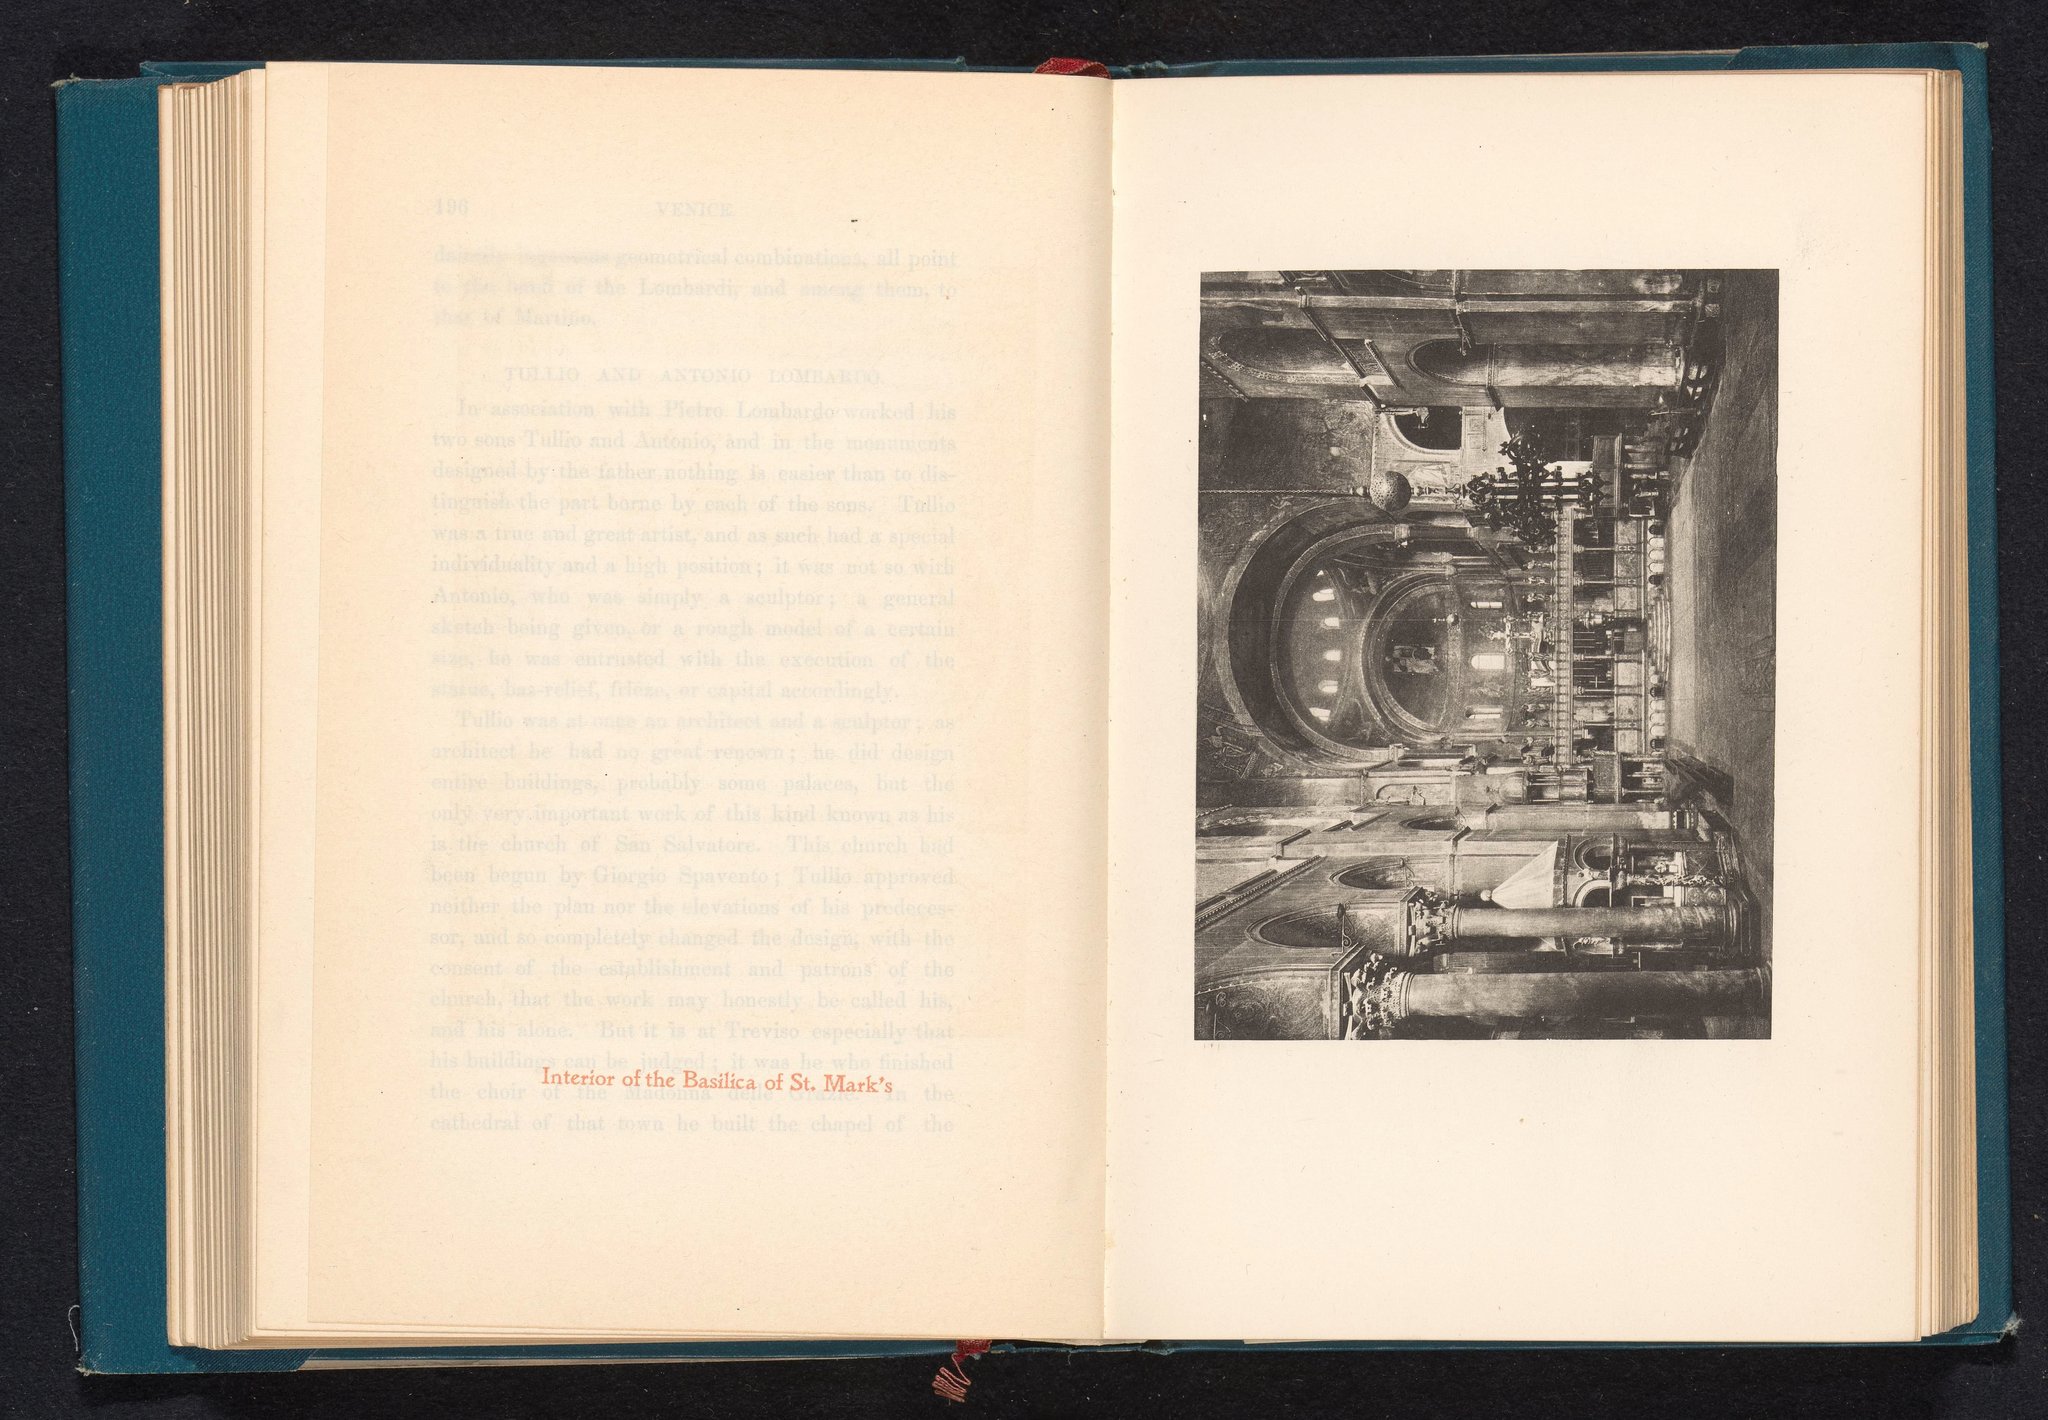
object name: page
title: Interieur van de San Marco te Venetië met zicht op het koor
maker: Anonymous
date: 1882-1892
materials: paper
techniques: photoaquatint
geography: st. mark's basilica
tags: interior of church, parts of church interior: choir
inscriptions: title: ‘Interior of the Basilica of St. Mark's’